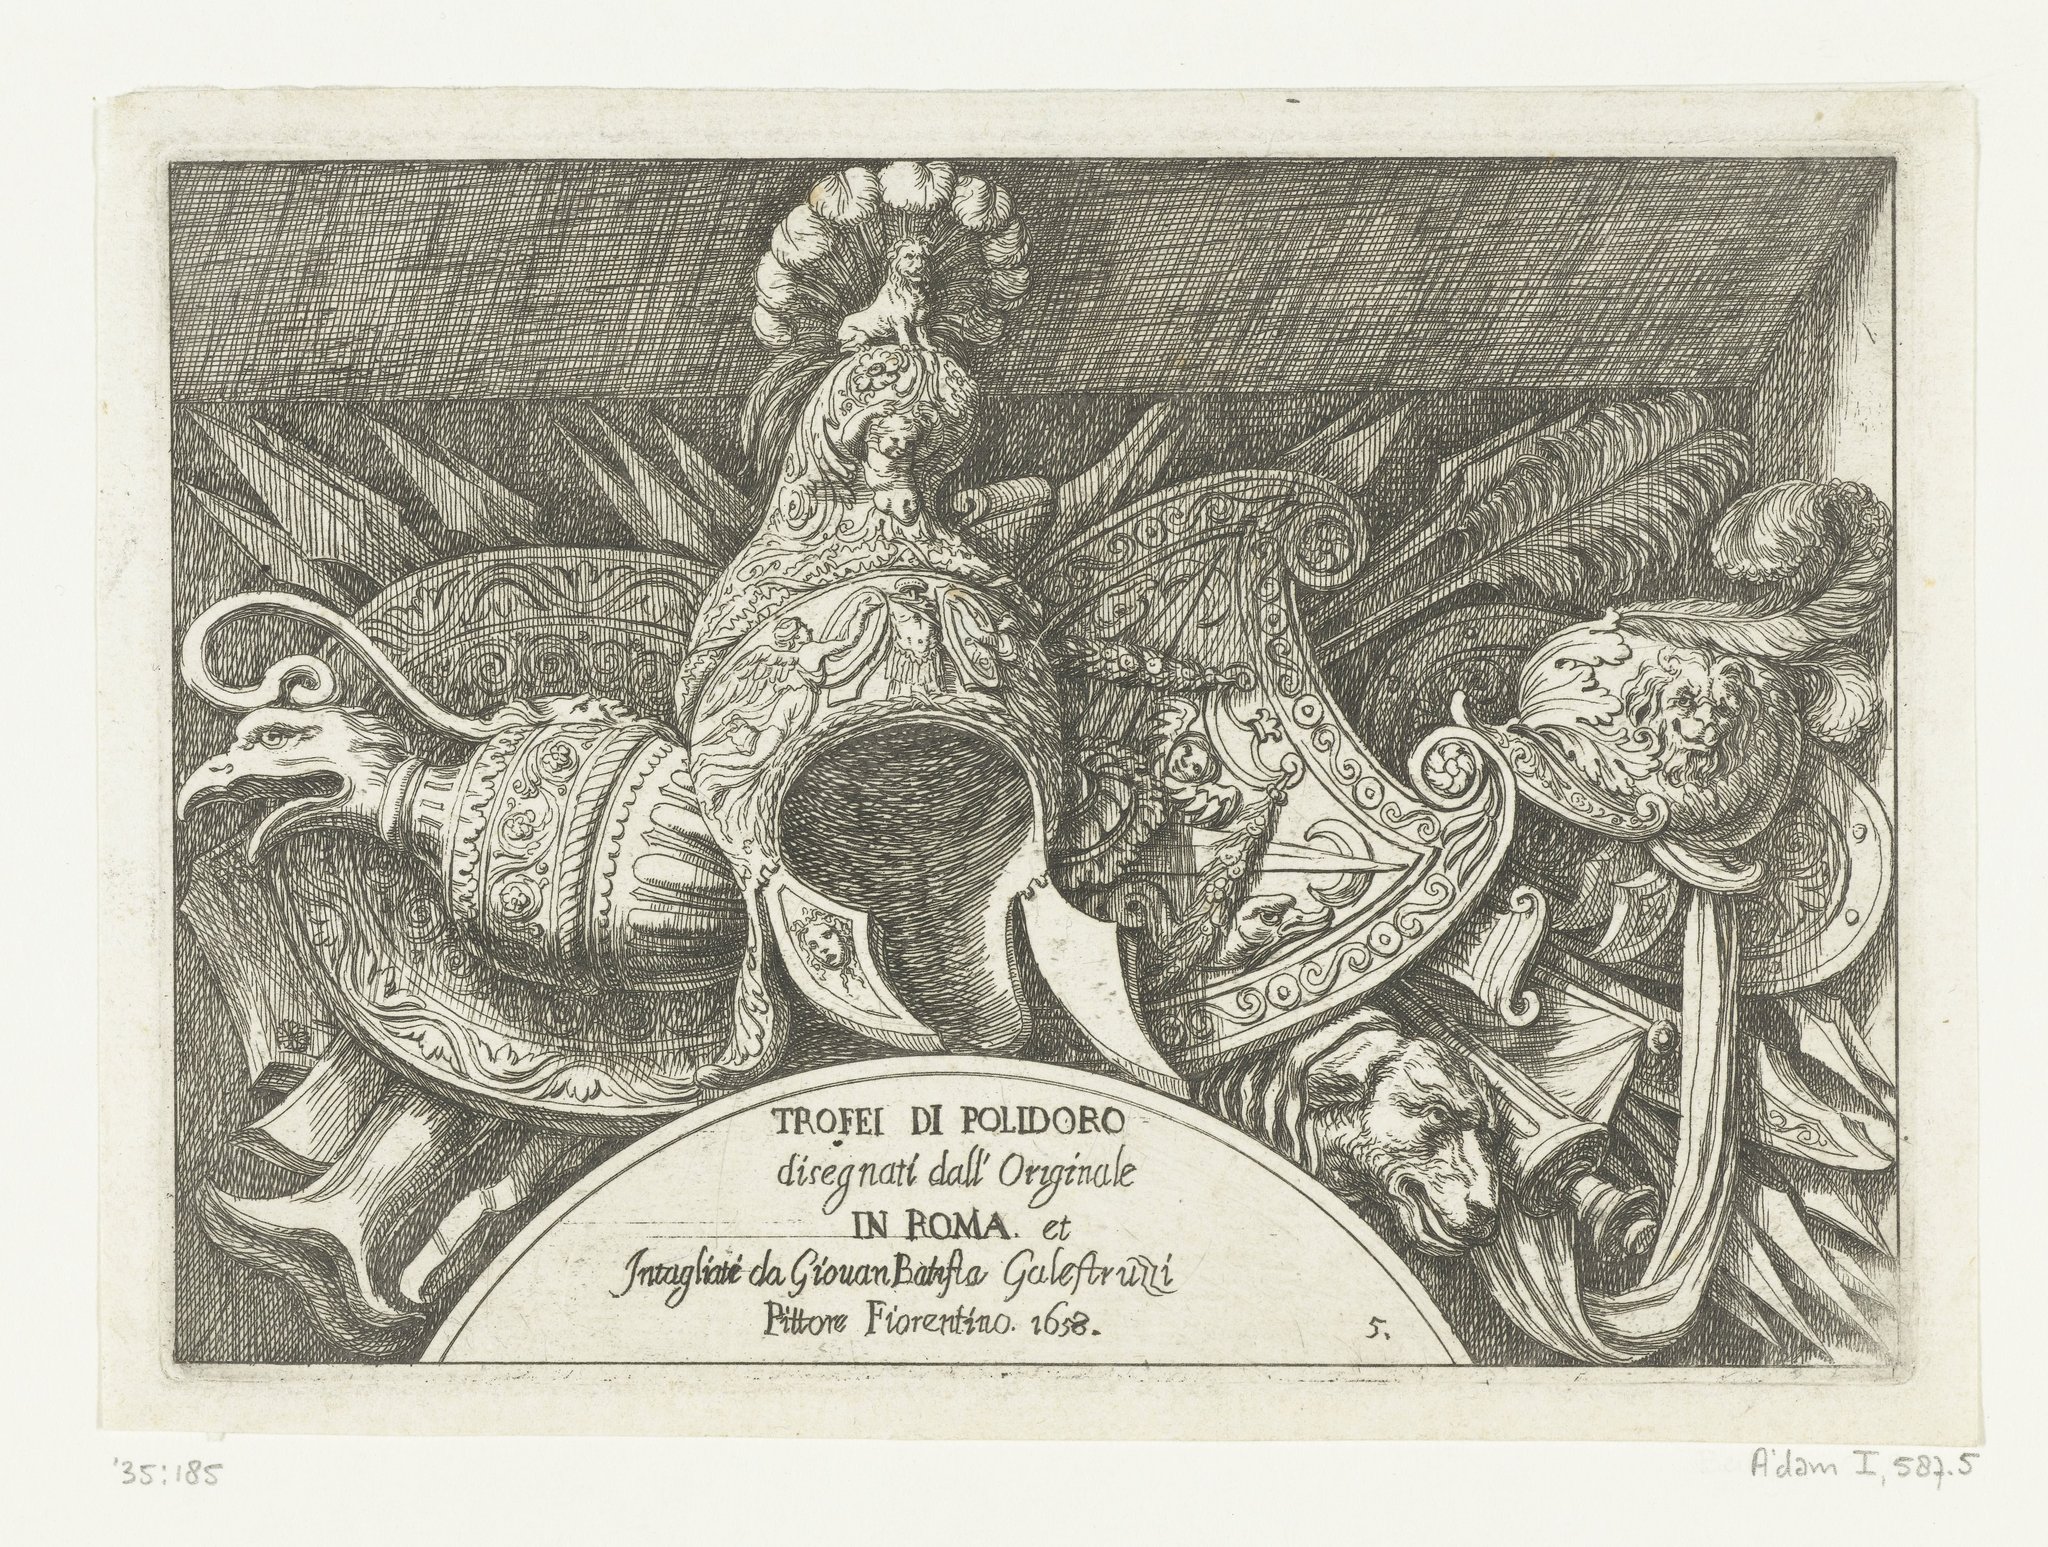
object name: print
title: Helm, bekroond door een zittende leeuw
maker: giovanni battista galestruzzi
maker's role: painter, print maker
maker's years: 1618-1661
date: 1658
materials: paper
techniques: etching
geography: italy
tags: helmet, beasts of prey, predatory animals: lion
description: Links liggen een schild en een kan met een tuit in de vorm van een vogelkop. Wapentrofee, liggend in een vierkante nis. Midden onder bevindt zich een halfrond wit vlak met inscriptie.